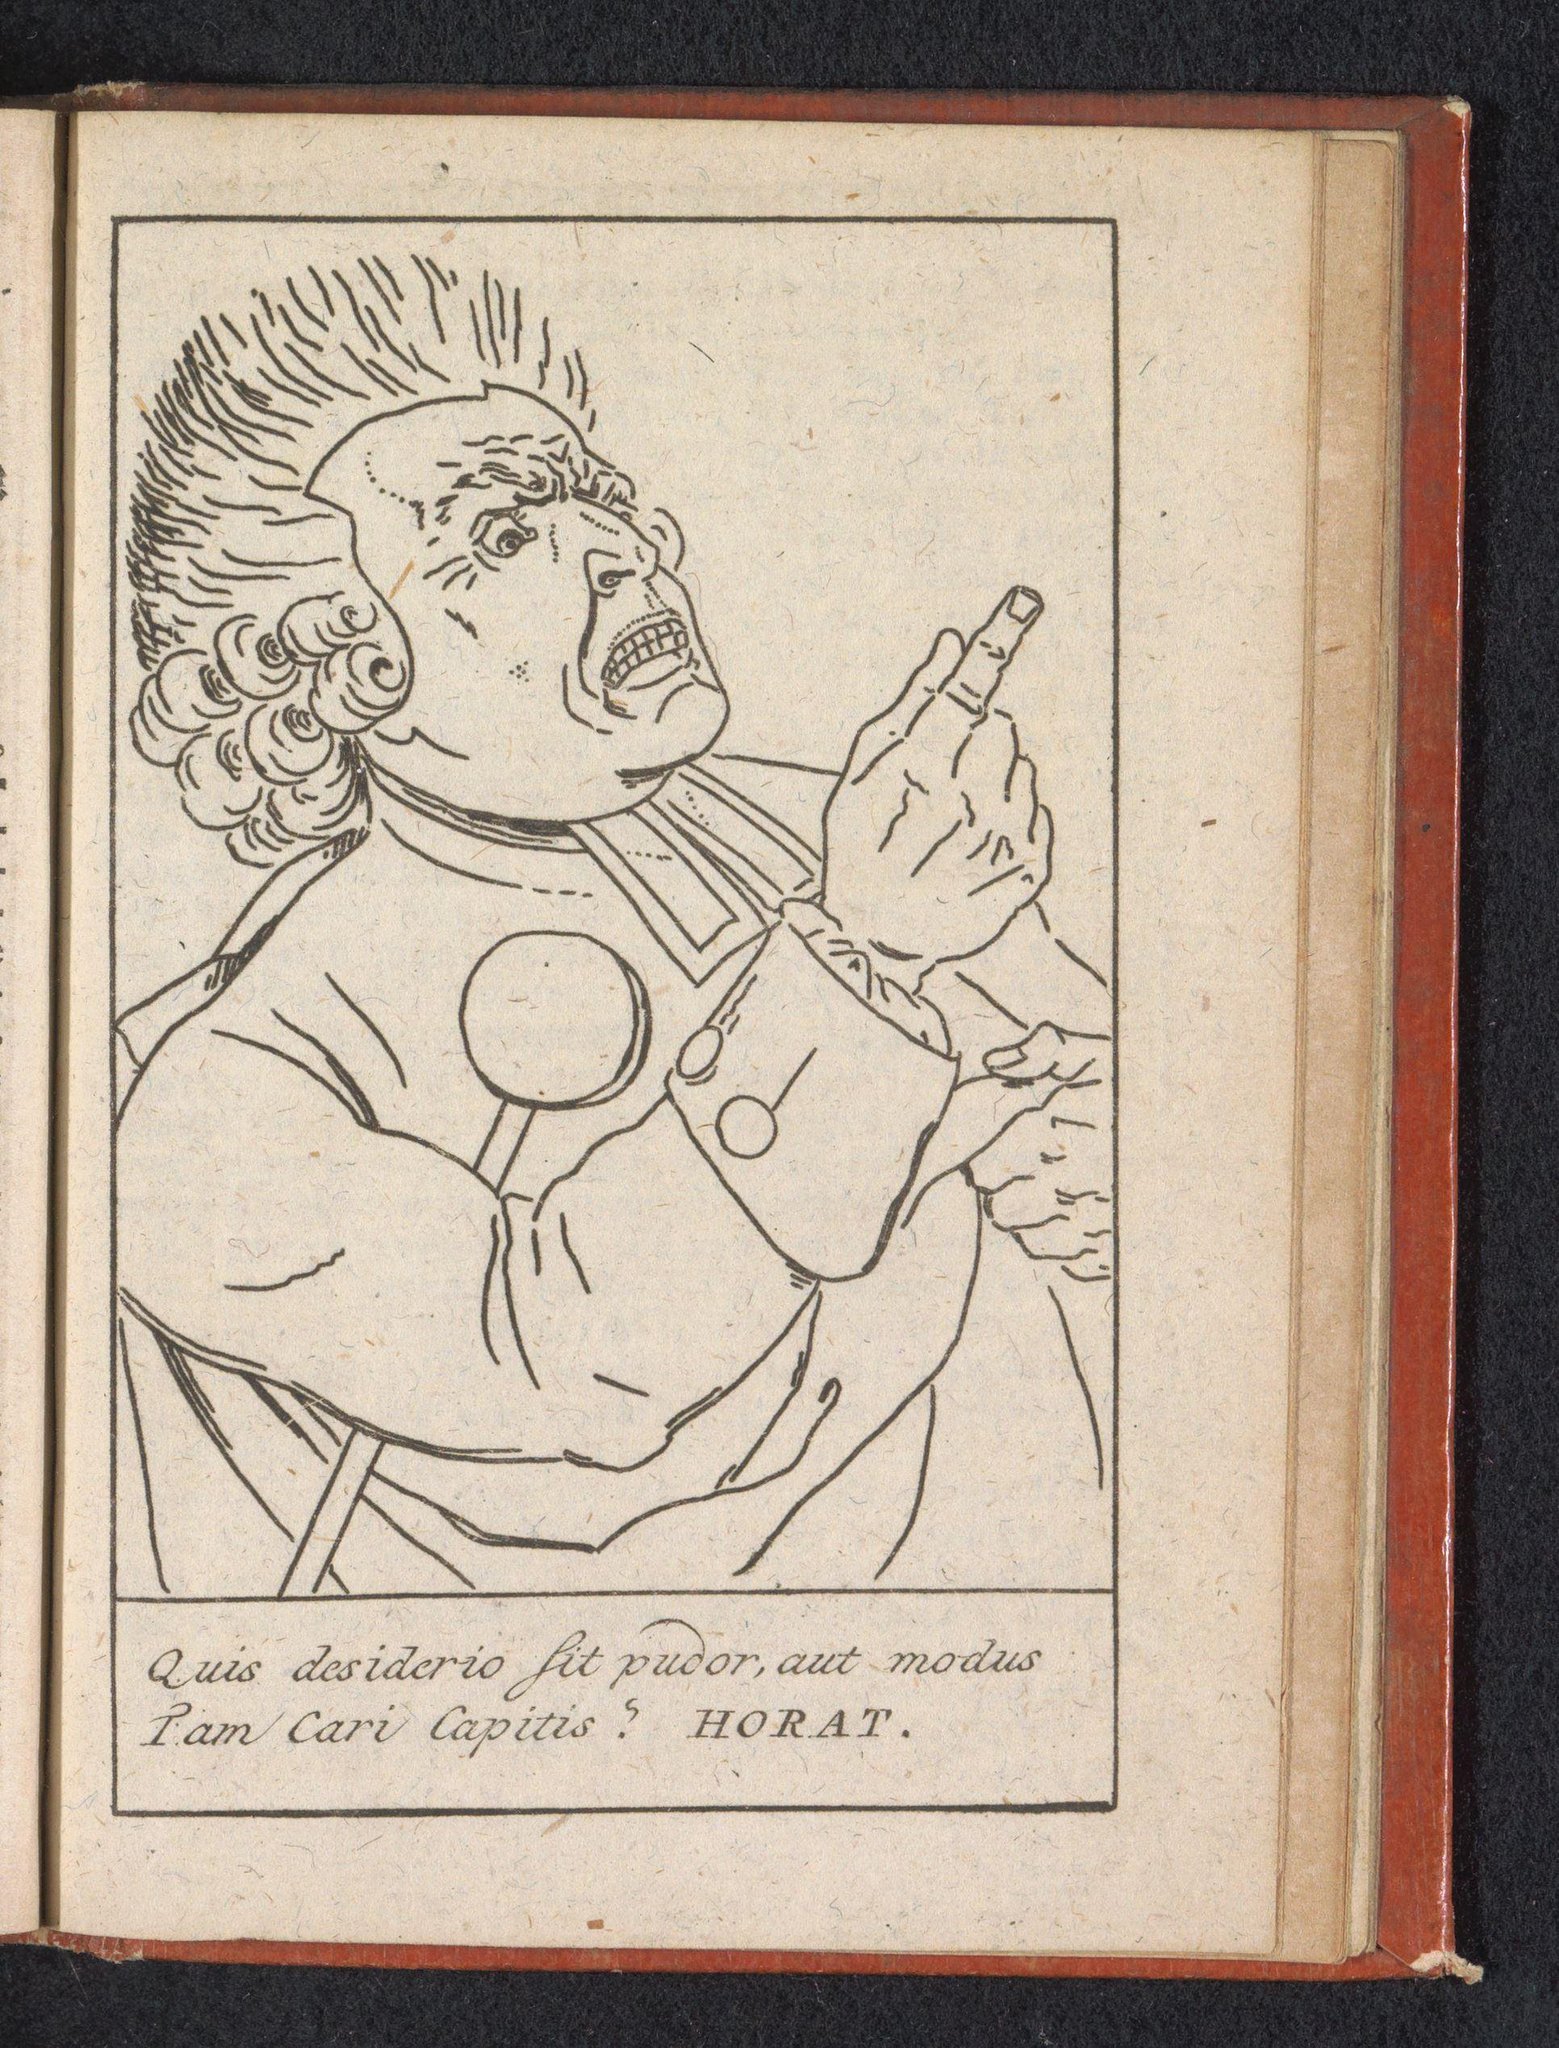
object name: book illustration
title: Boze schoolmeester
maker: pieter van woensel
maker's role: print maker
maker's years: 1747-1808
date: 1792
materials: paper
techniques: etching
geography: northern netherlands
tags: teacher and pupil (+ teacher, professor), rage, anger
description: Een boze schoolmeester met een plak onder de arm. Met tweeregelig onderschrift in het Latijn. Illustratie in Pieter van Woensels almanak 'De Lantaarn voor 1792'.